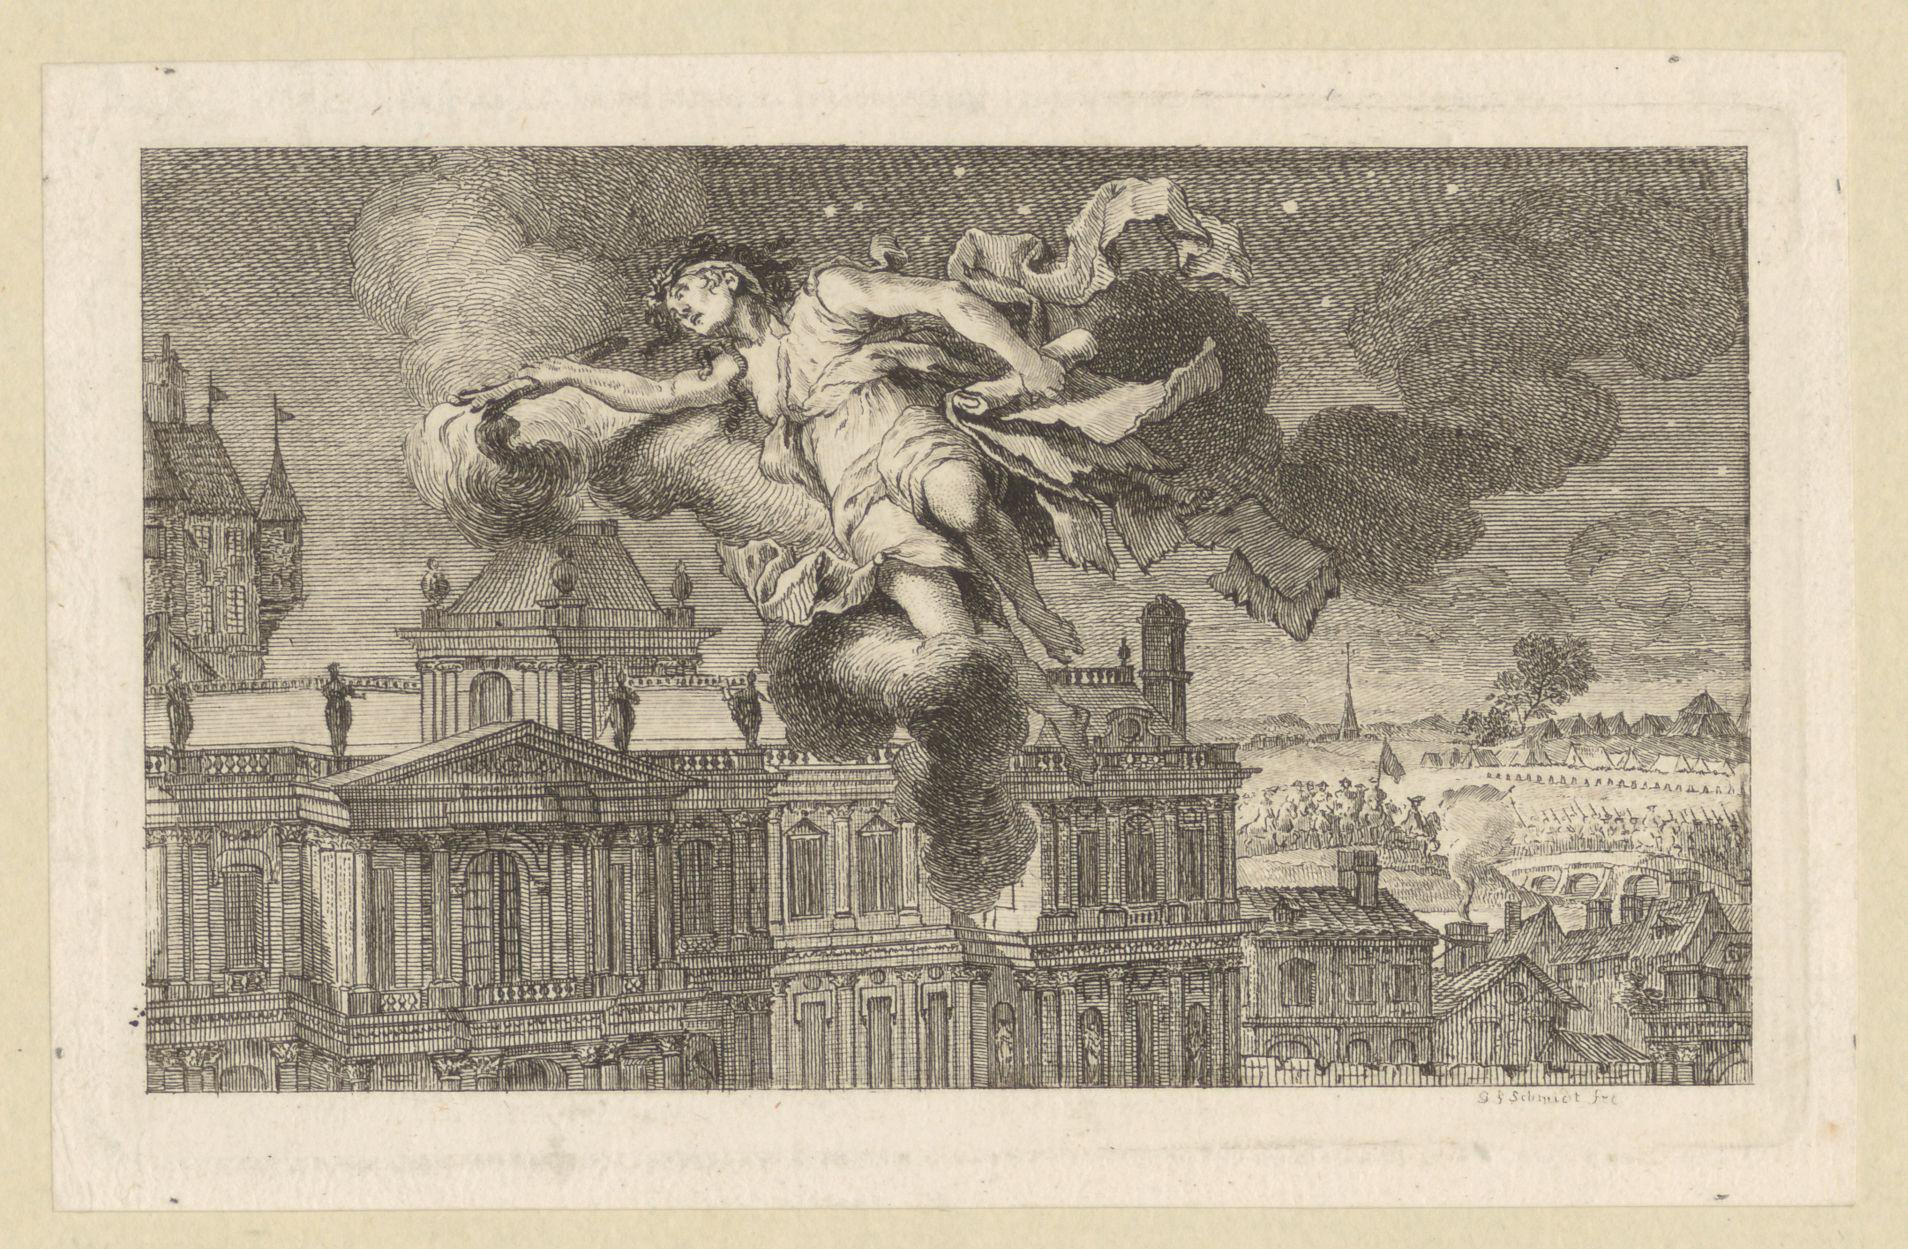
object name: print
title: Krijgsfurie zweeft met brandende fakkel over een slot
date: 1760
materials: paper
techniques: etching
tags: furies, dirae (erinyes), eumenides; 'furie' (ripa), symbols, allegories of war; 'guerra' (ripa)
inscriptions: collector's mark: Lugt 240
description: Prent ook gebruikt in: Frederik de Grote. Poësies diverses. Sanssouci, Frederik de Grote, 1760.